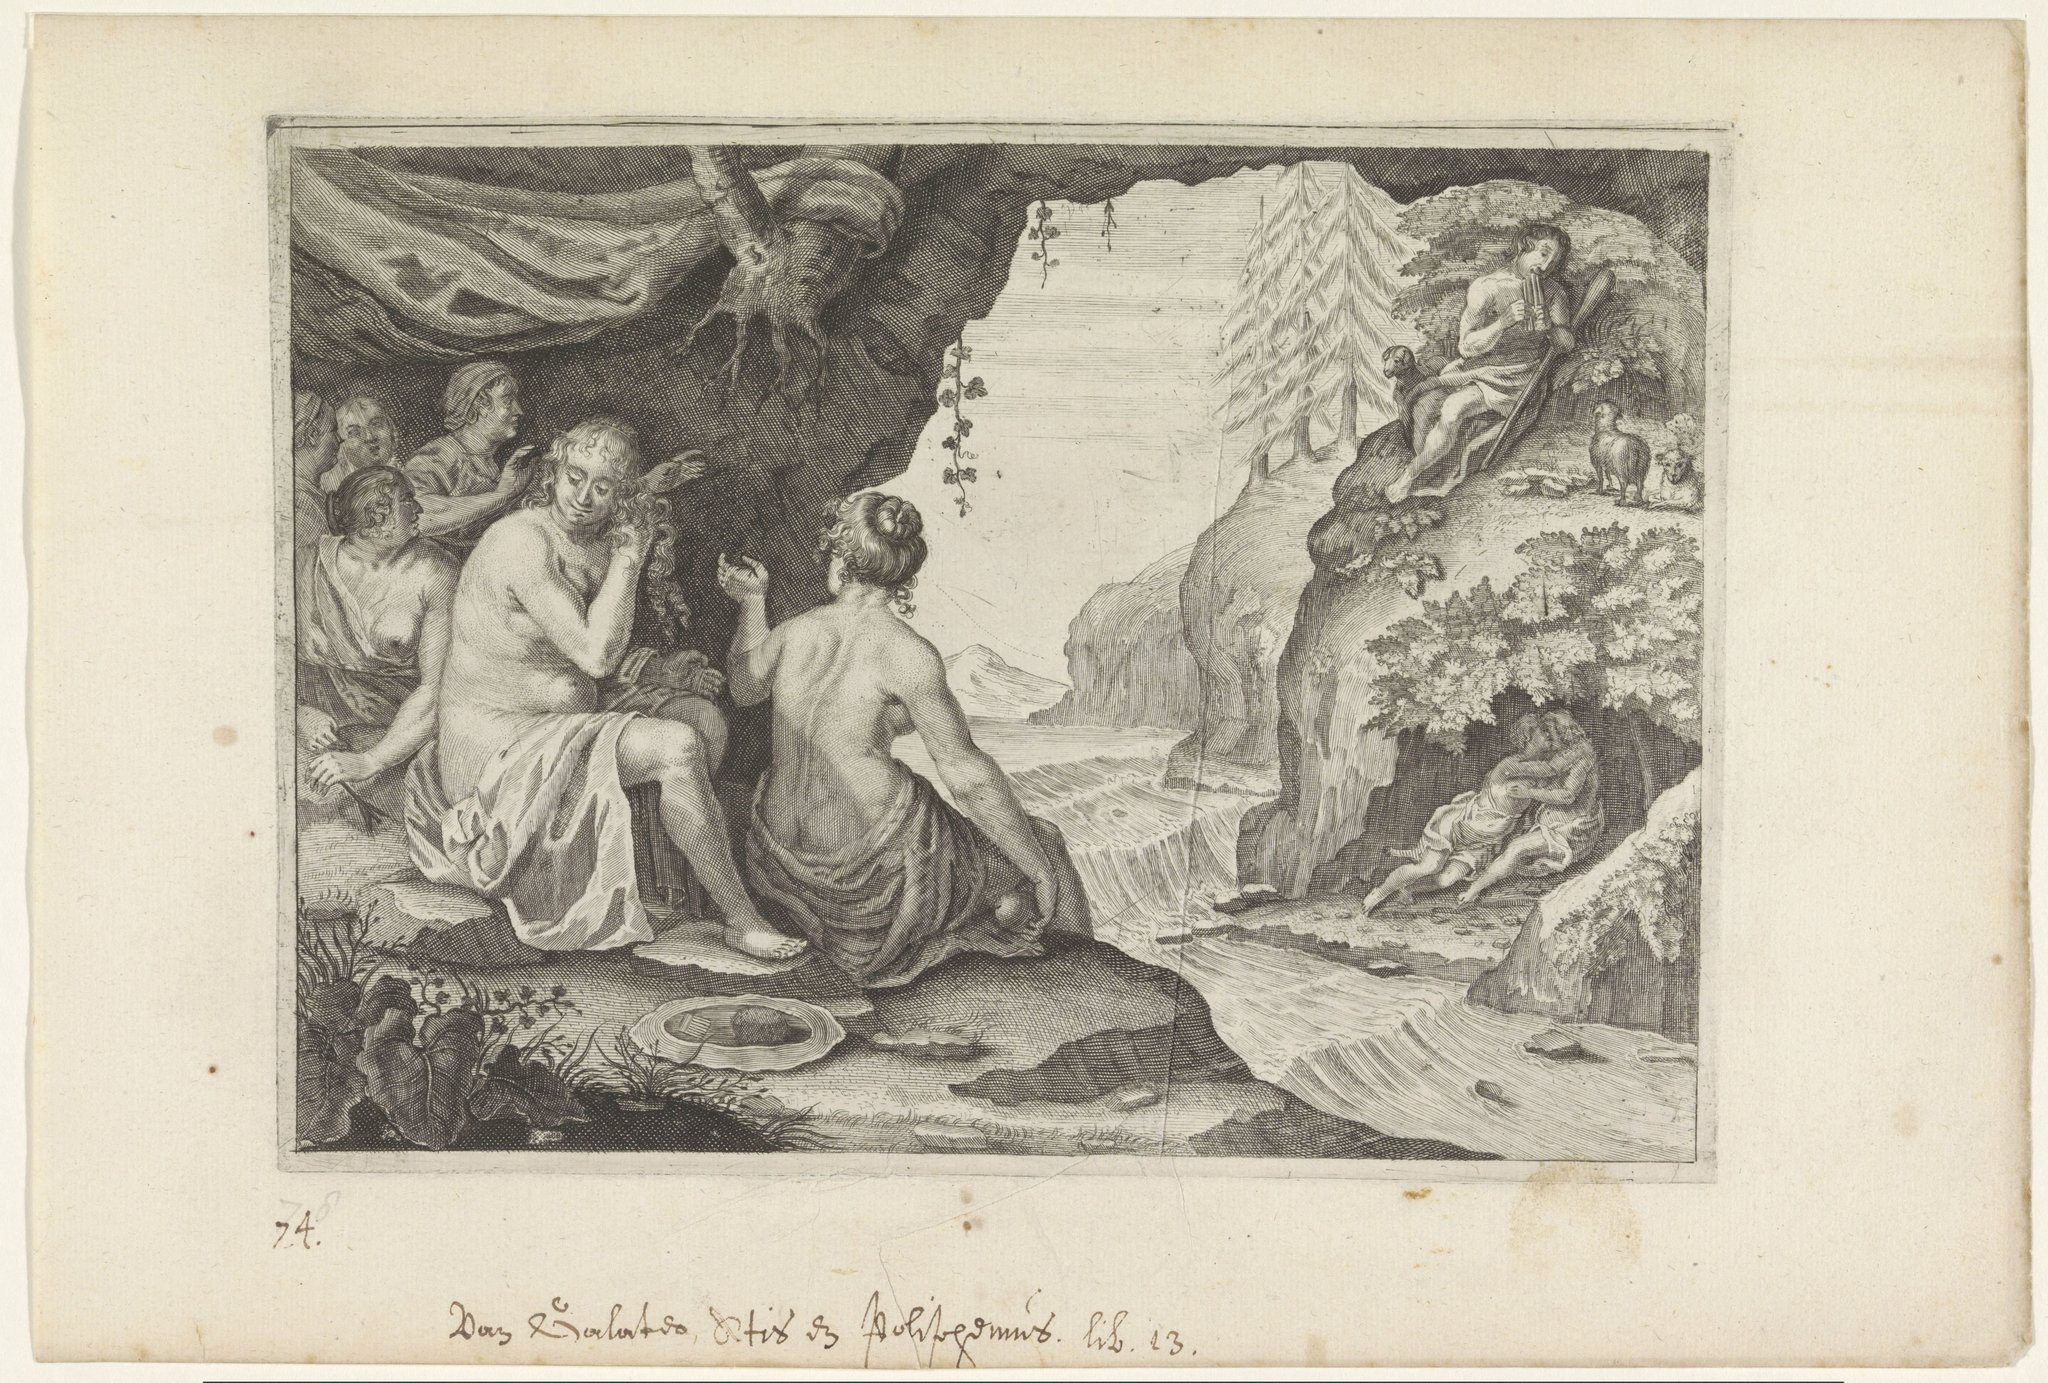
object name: print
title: Metamorfosen van Ovidius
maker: crispijn van de passe (ii)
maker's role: draughtsman, print maker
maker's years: 1594-1670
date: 1636-1670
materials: paper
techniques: engraving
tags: acis wooing galatea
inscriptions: number: ‘74’, annotation: ‘Van Galatea, Atis en Polyphemus. lib. 13.’, collector's mark: ‘Hinloopen’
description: Deze incomplete serie, bestaande uit 77 van de in totaal 85 prenten met scènes uit Ovidius' Metamorfosen, werd in 1709 samen met Ovidius-illustraties van Tempesta, Goltzius en Le Pautre in één album, Schijnvoet nummer 43, ingebonden. In de negentiende eeuw werd deze band weer uit elkaar gehaald.